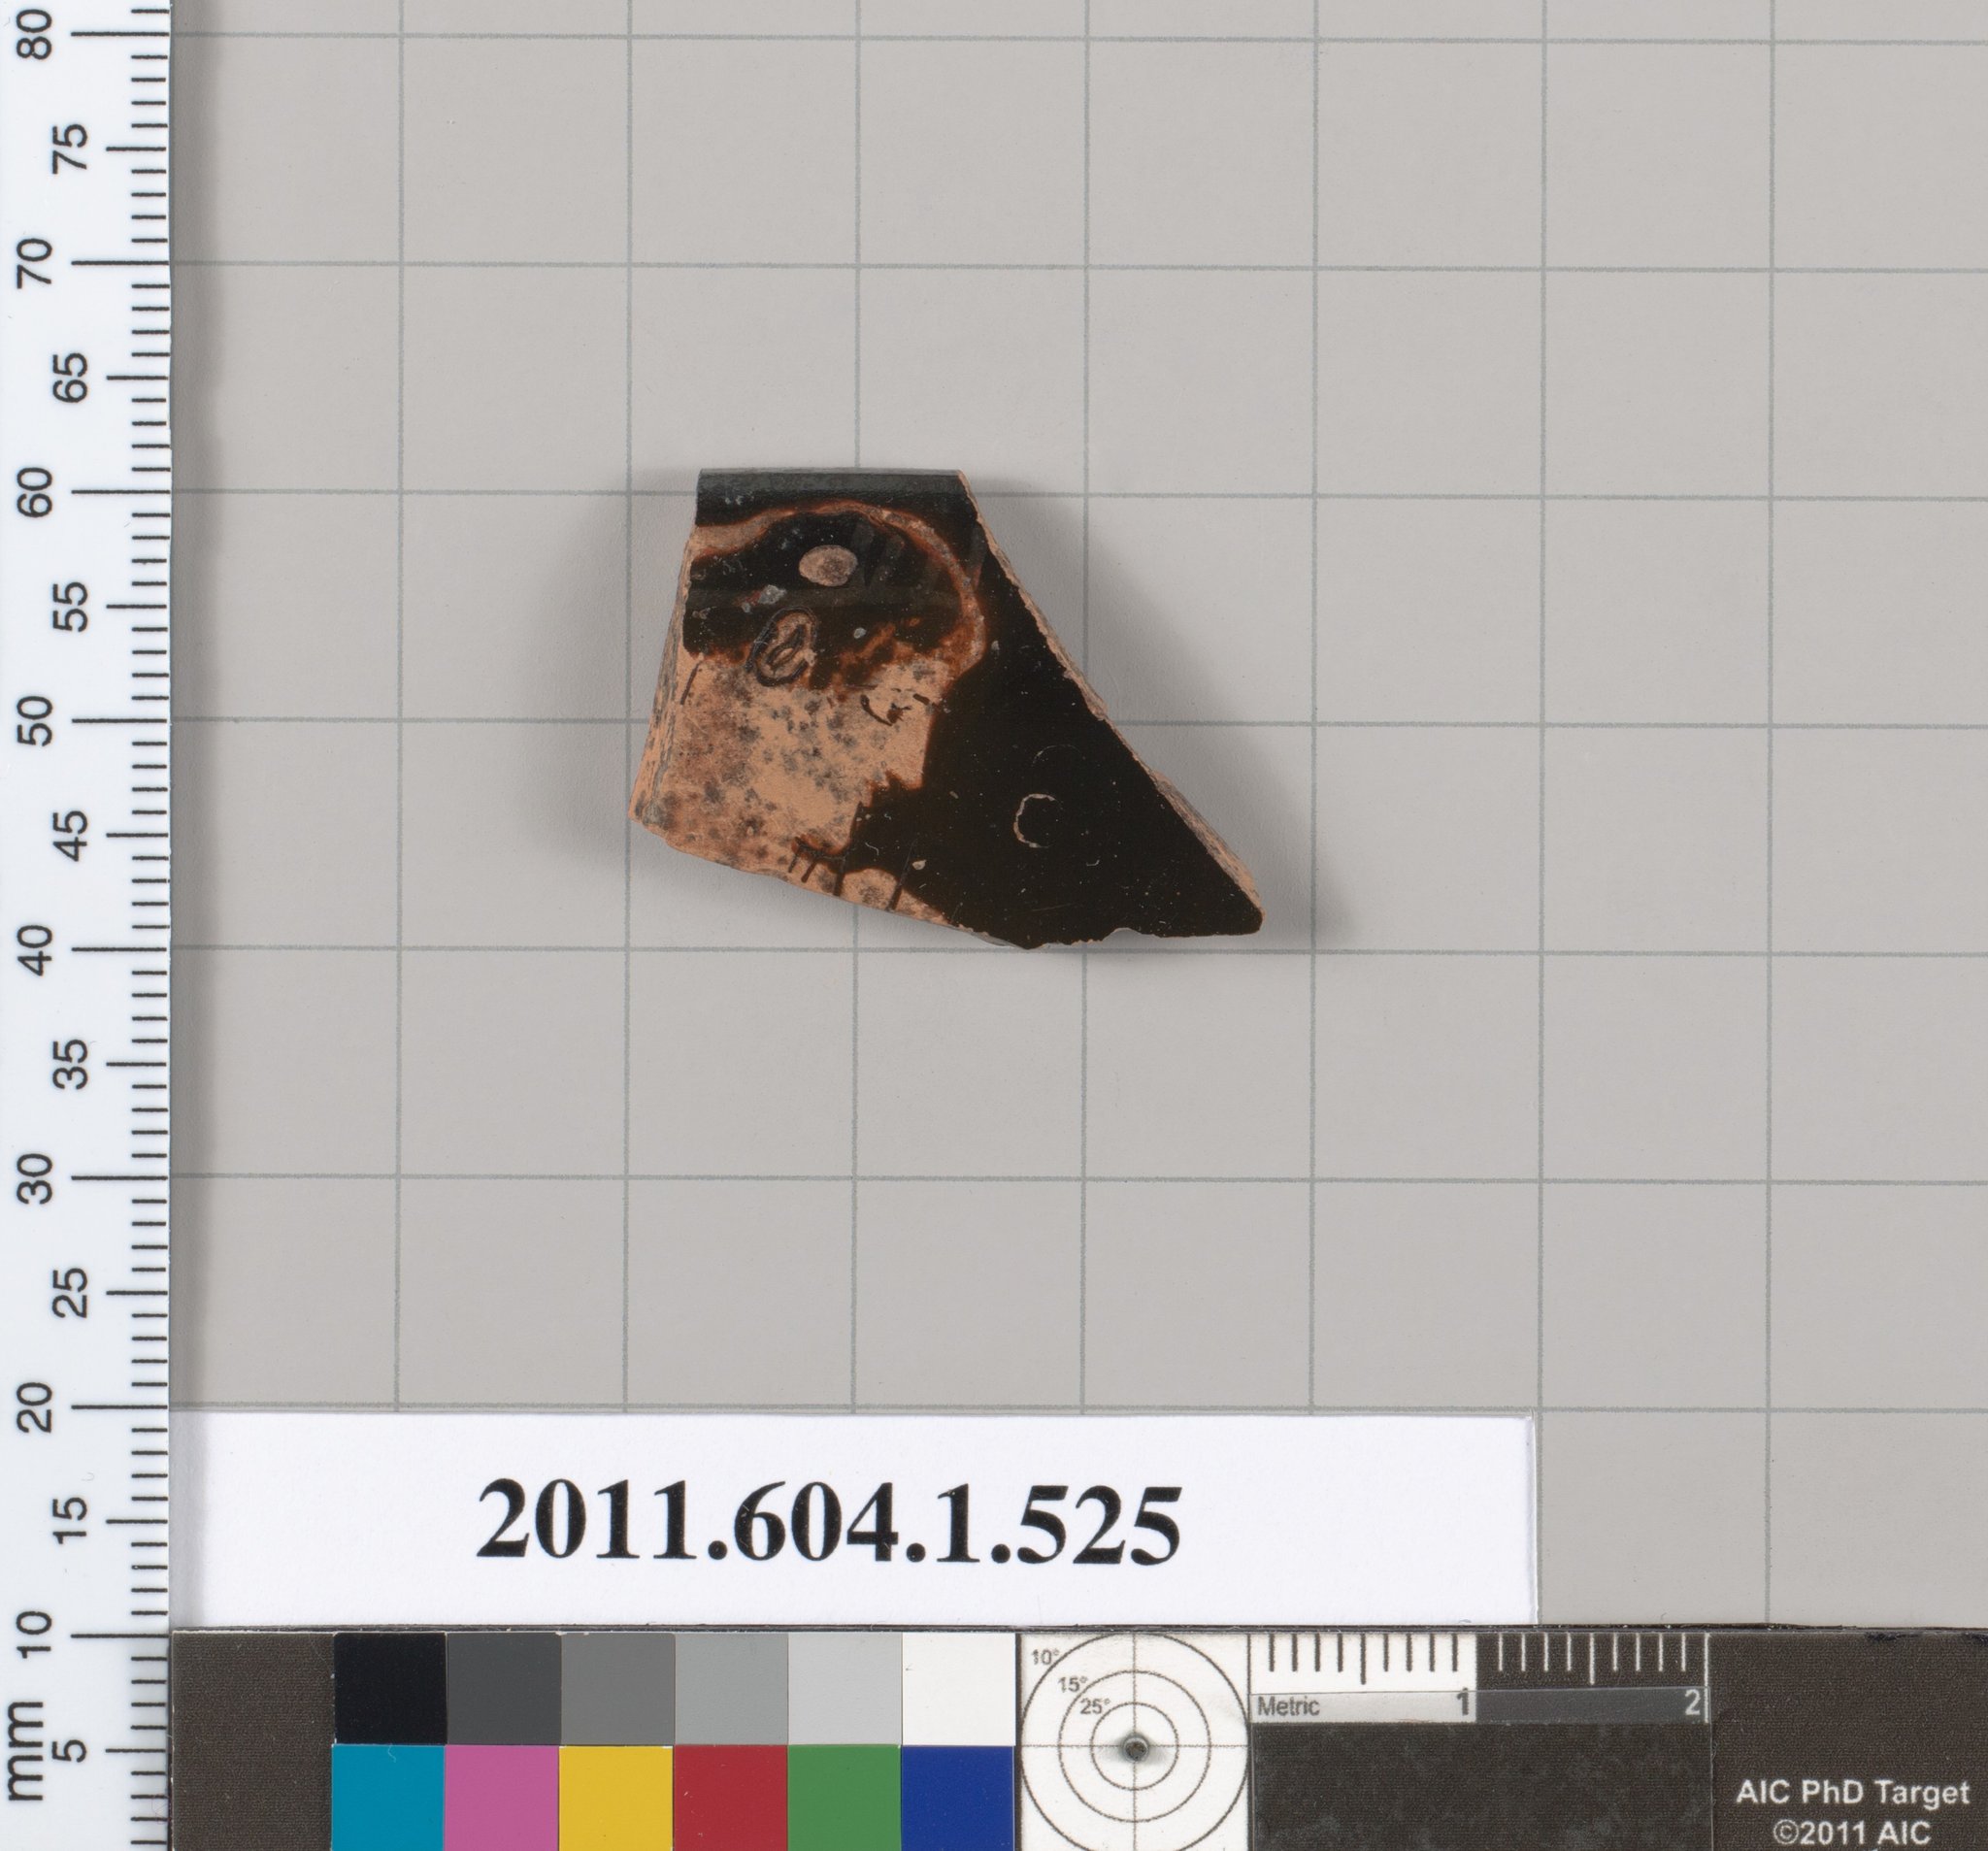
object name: kylix fragment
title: Terracotta rim fragment of a kylix (drinking cup)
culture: greek, attic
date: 480-470 BCE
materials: terracotta